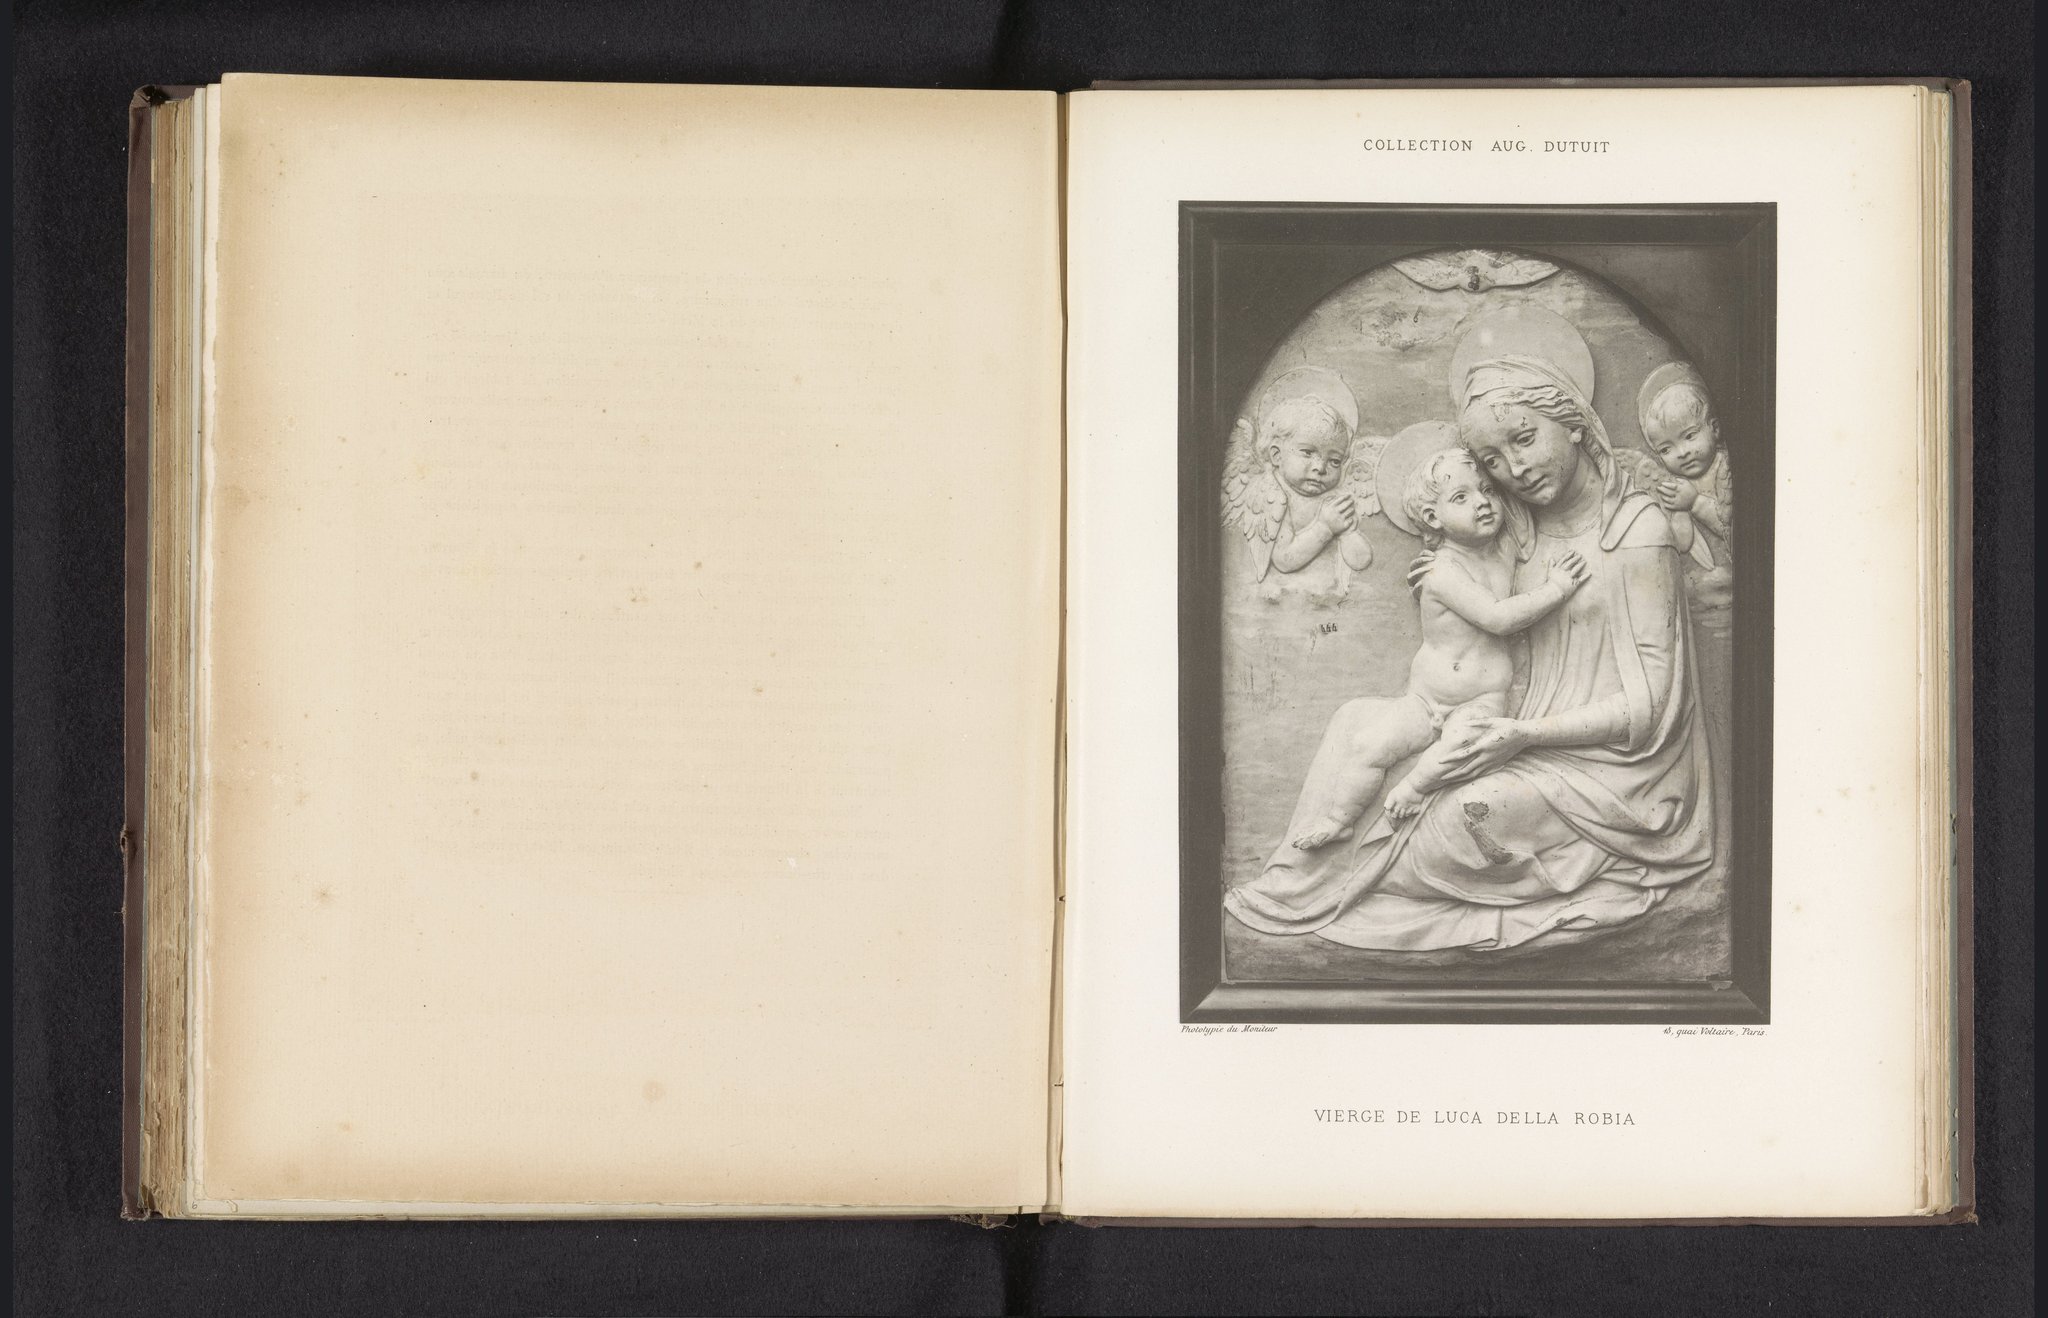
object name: page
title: Maria met kind door Luca della Robbia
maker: Anonymous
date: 1879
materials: paper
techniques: photograph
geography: paris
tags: madonna: i.e. mary with the christ-child, piece of sculpture, reproduction of a piece of sculpture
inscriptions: inscription: ‘Phototypie du Moniteur 15, quai Voltaire, Paris’